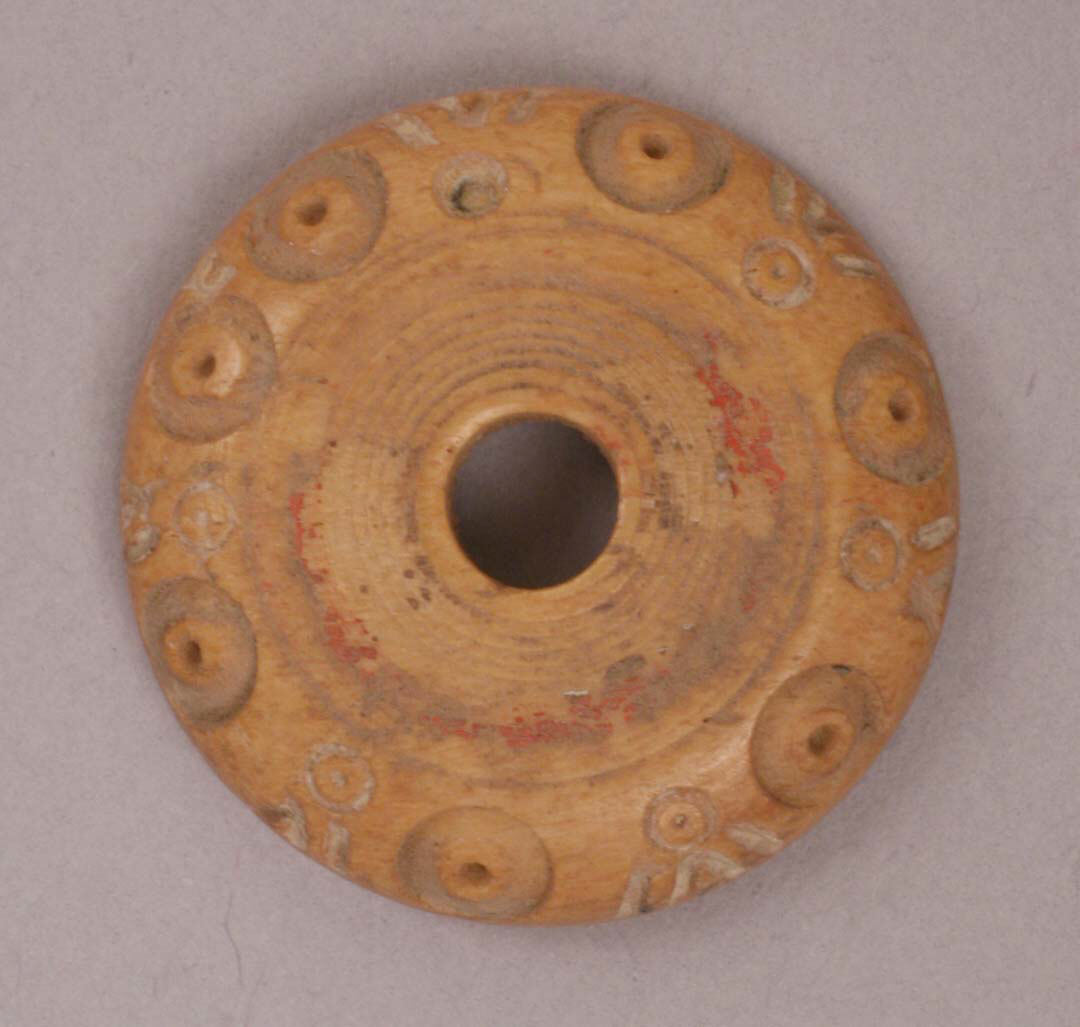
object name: button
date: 801-1000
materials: bone, paint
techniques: incising, inlay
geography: iran